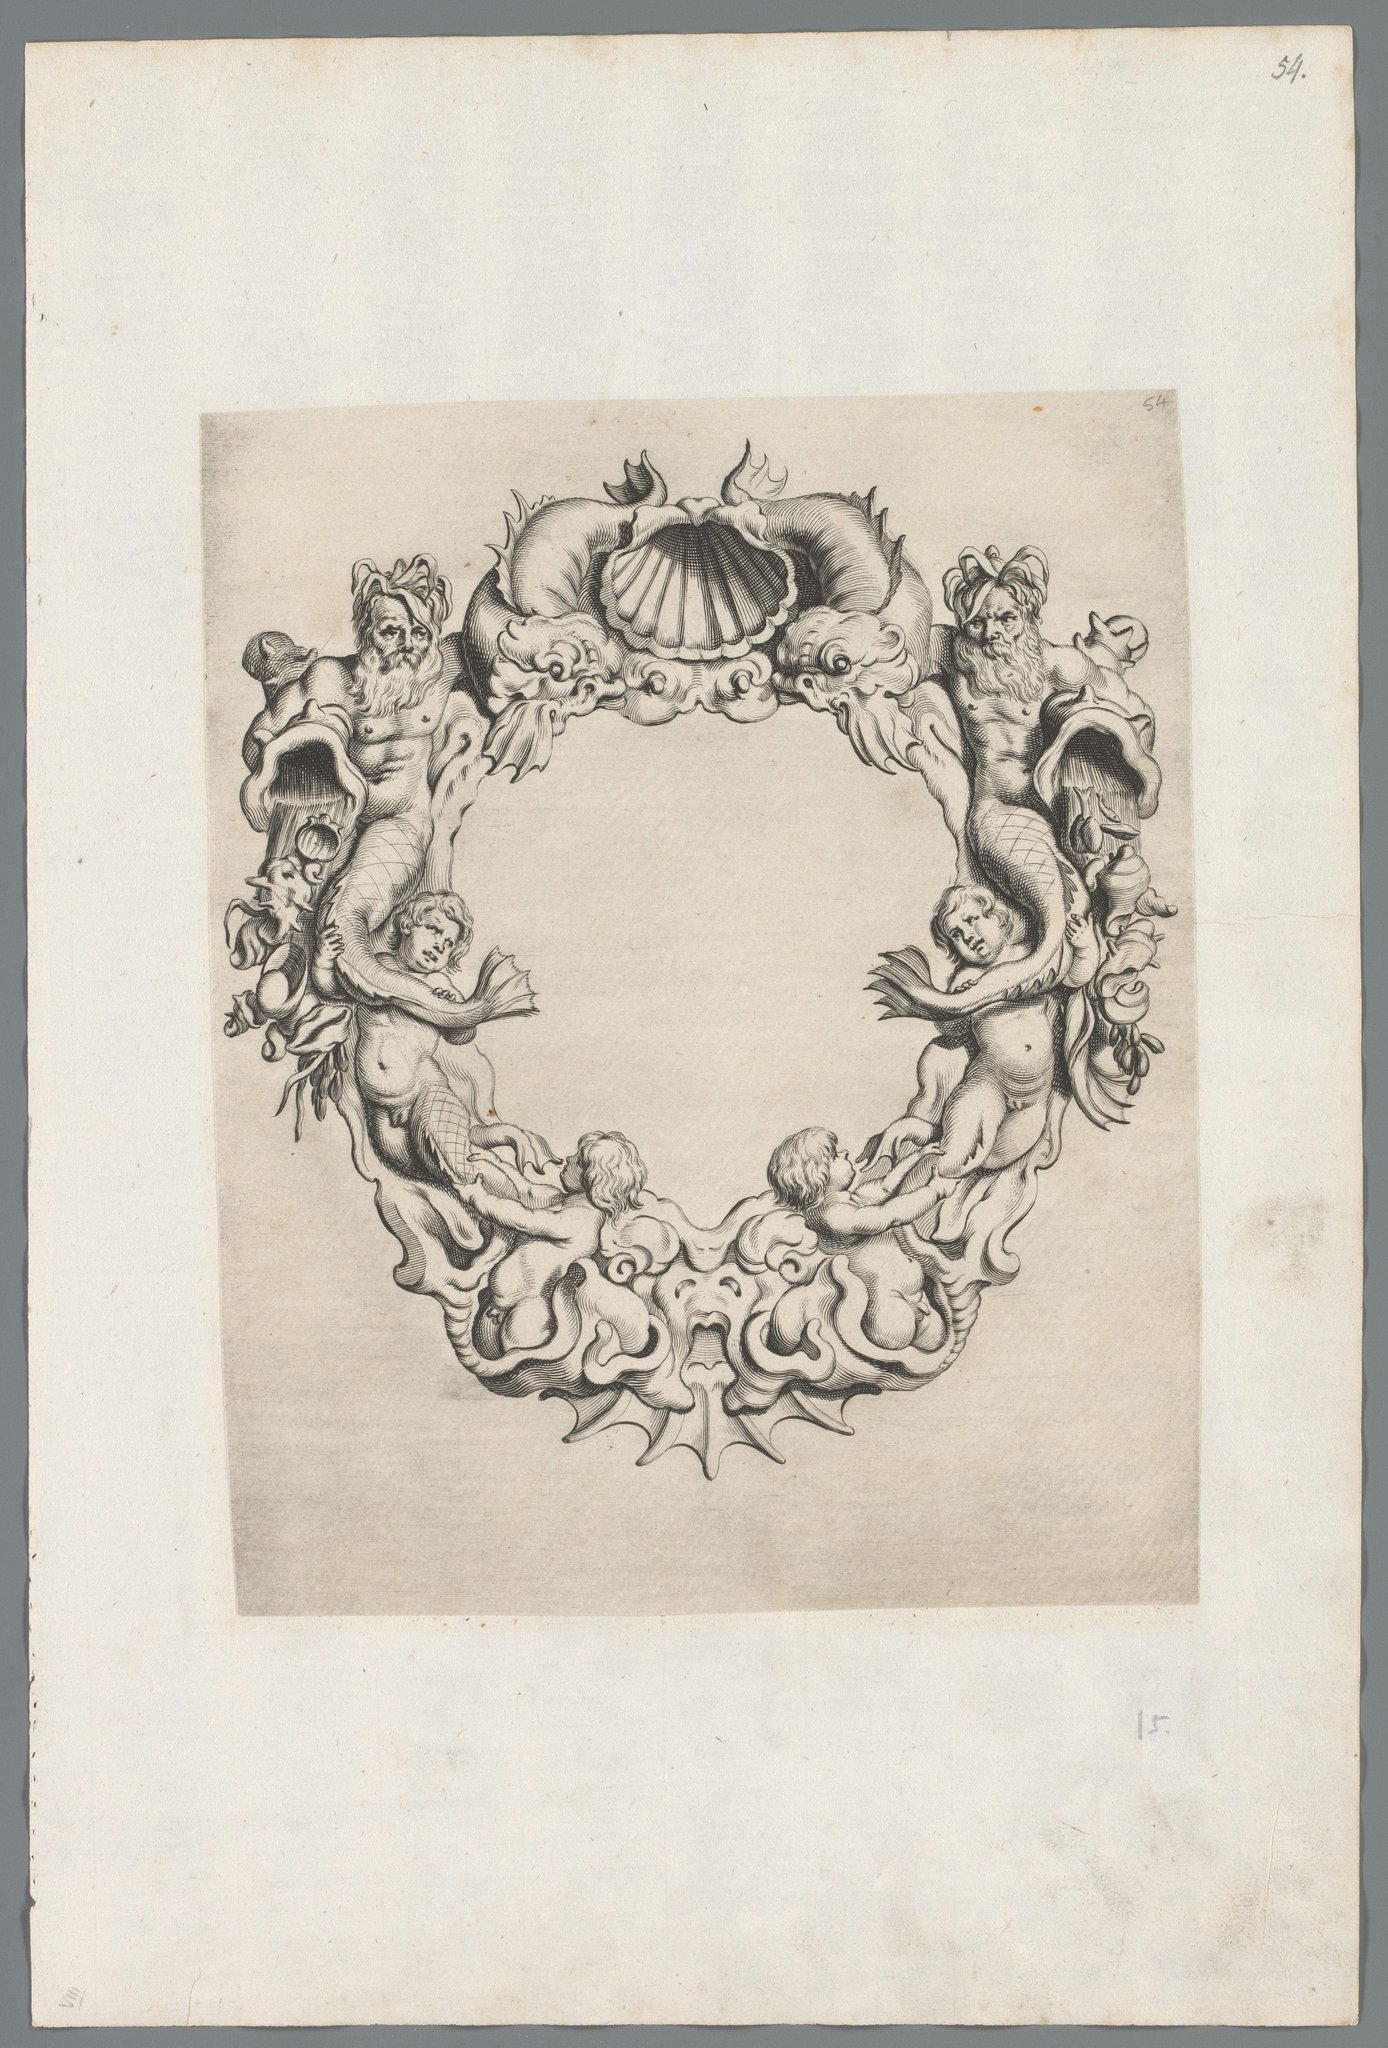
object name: print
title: Veelderhande niewe compartemente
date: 1640-1674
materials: paper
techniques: engraving, etching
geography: amsterdam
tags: auricular ornament, lobe style ~ ornament, ornament ~ cartouche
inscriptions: collector's mark: Lugt 2760, collector's mark: Lugt 2228